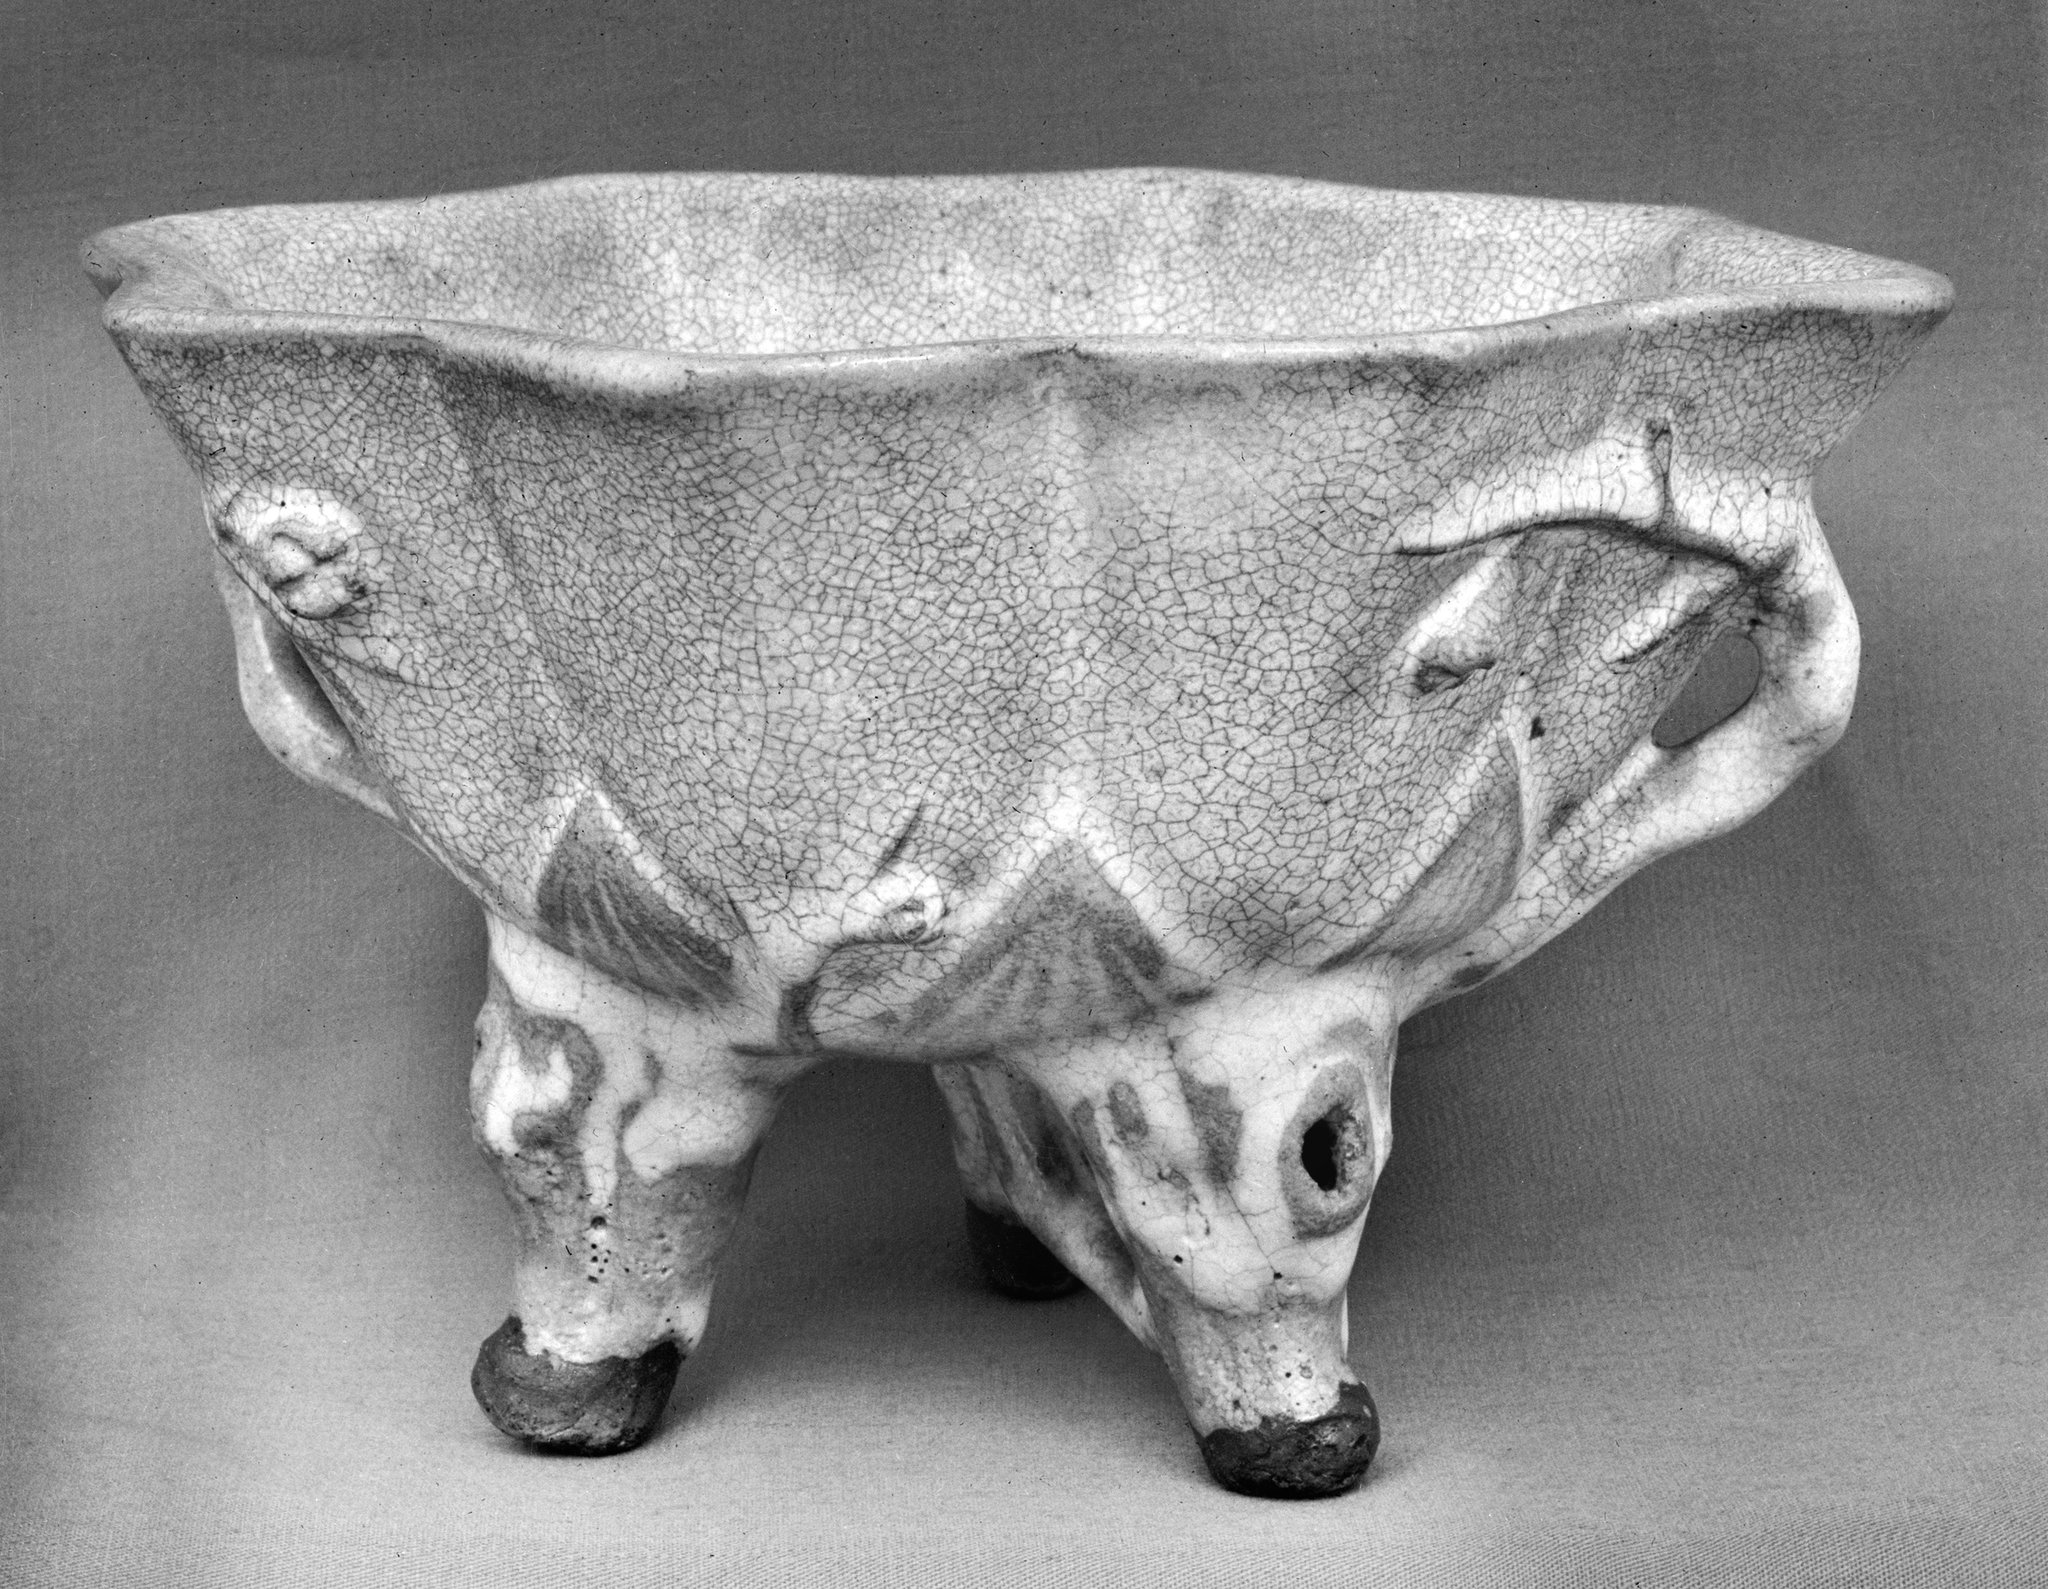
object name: cup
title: Lotus cup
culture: chinese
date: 1701-1800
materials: glaze, stoneware